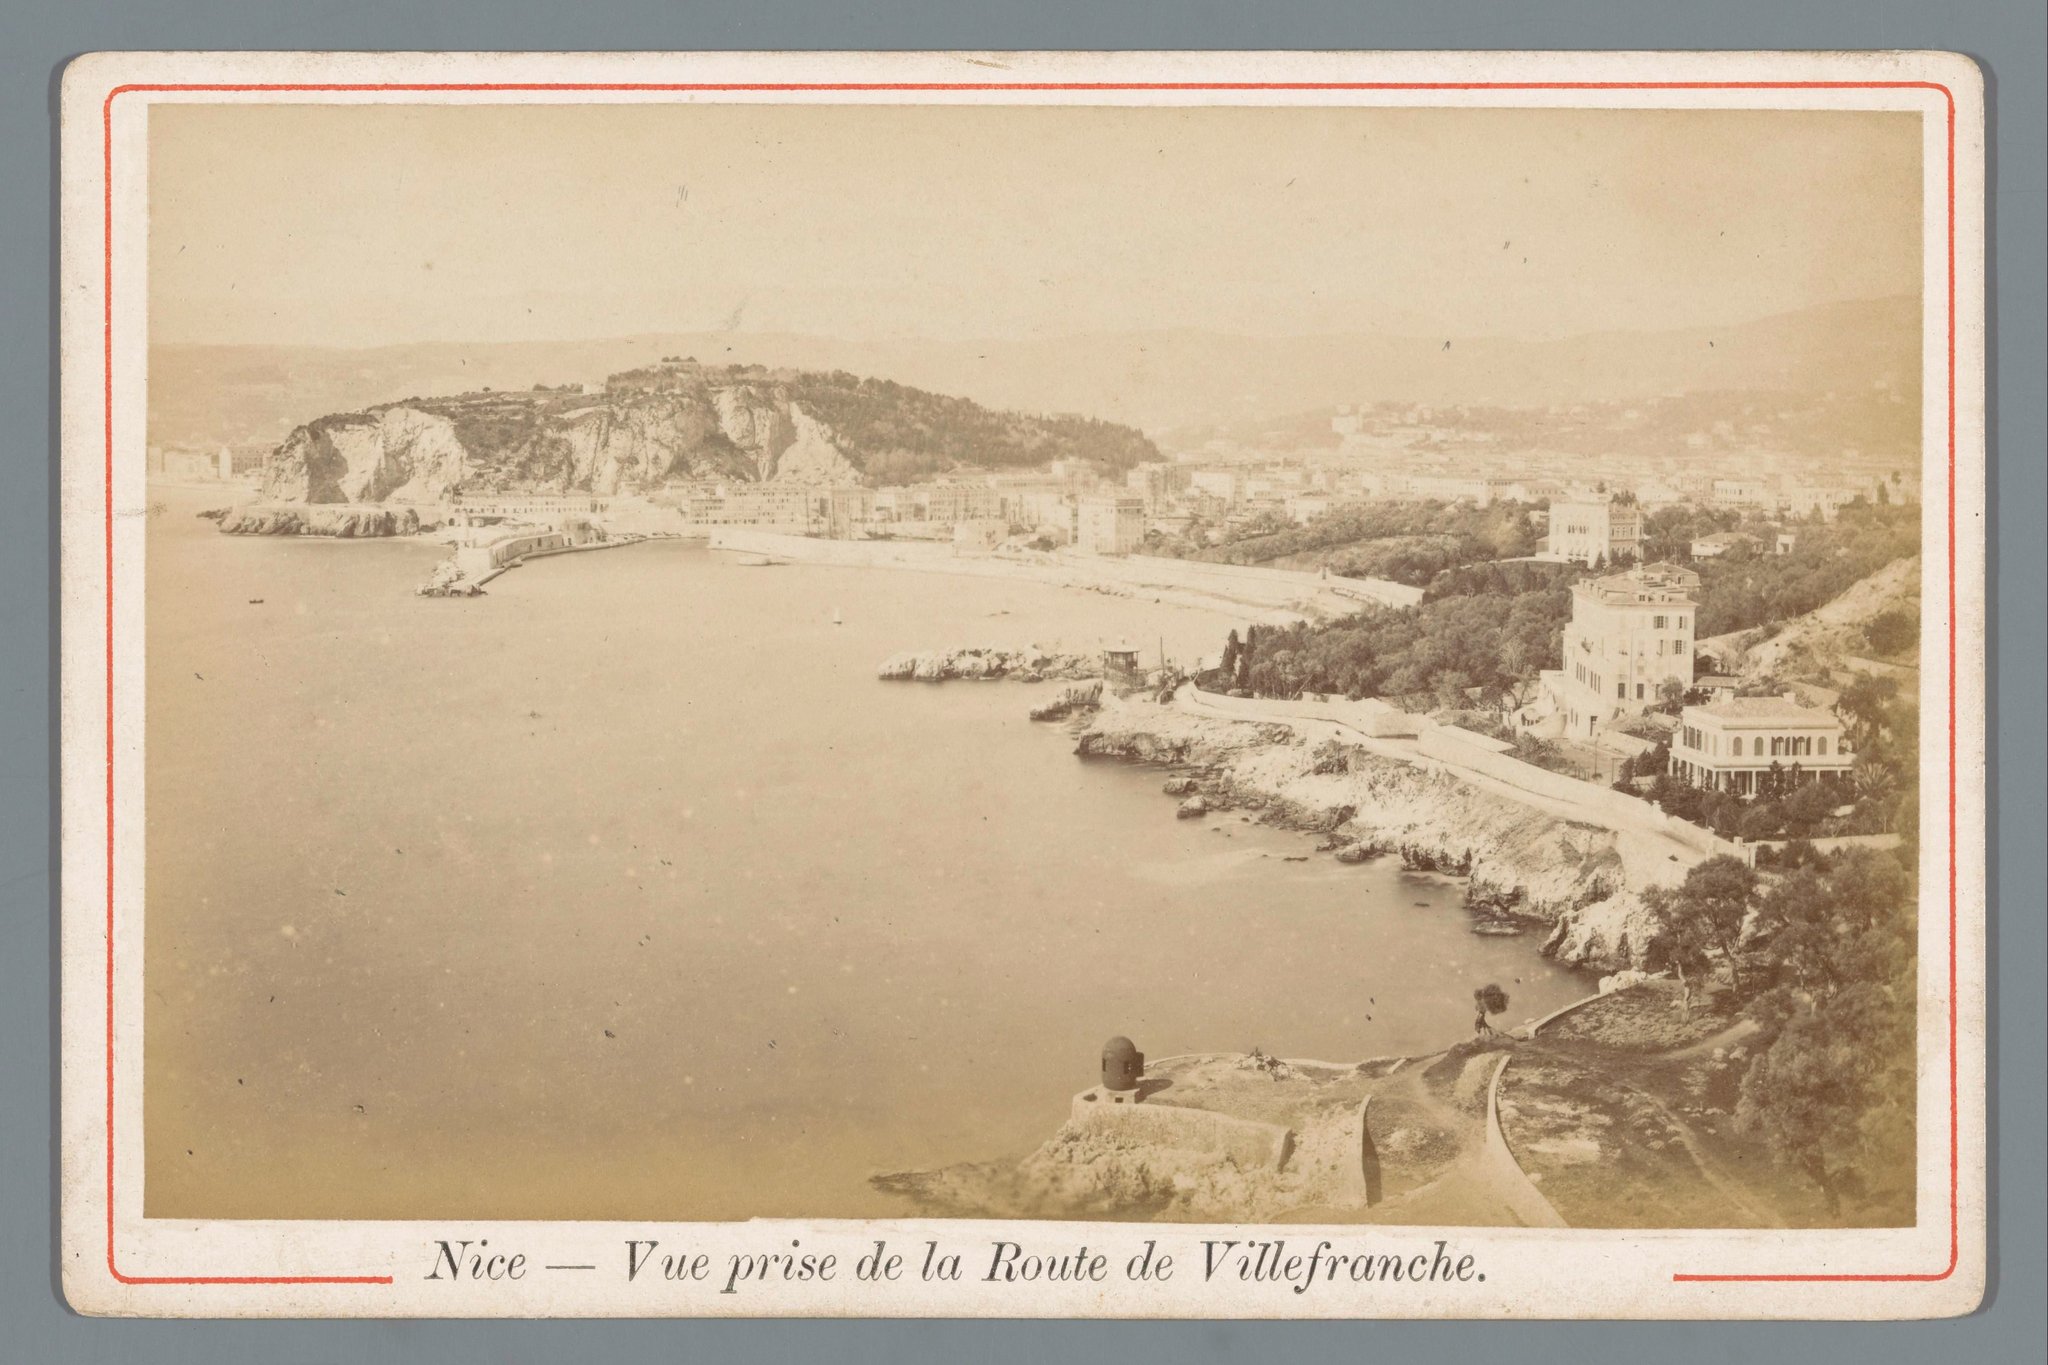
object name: cabinet photograph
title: Gezicht op Nice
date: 1872-1875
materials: cardboard, photographic support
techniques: albumen print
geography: nice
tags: city-view in general; 'veduta', quay, sea